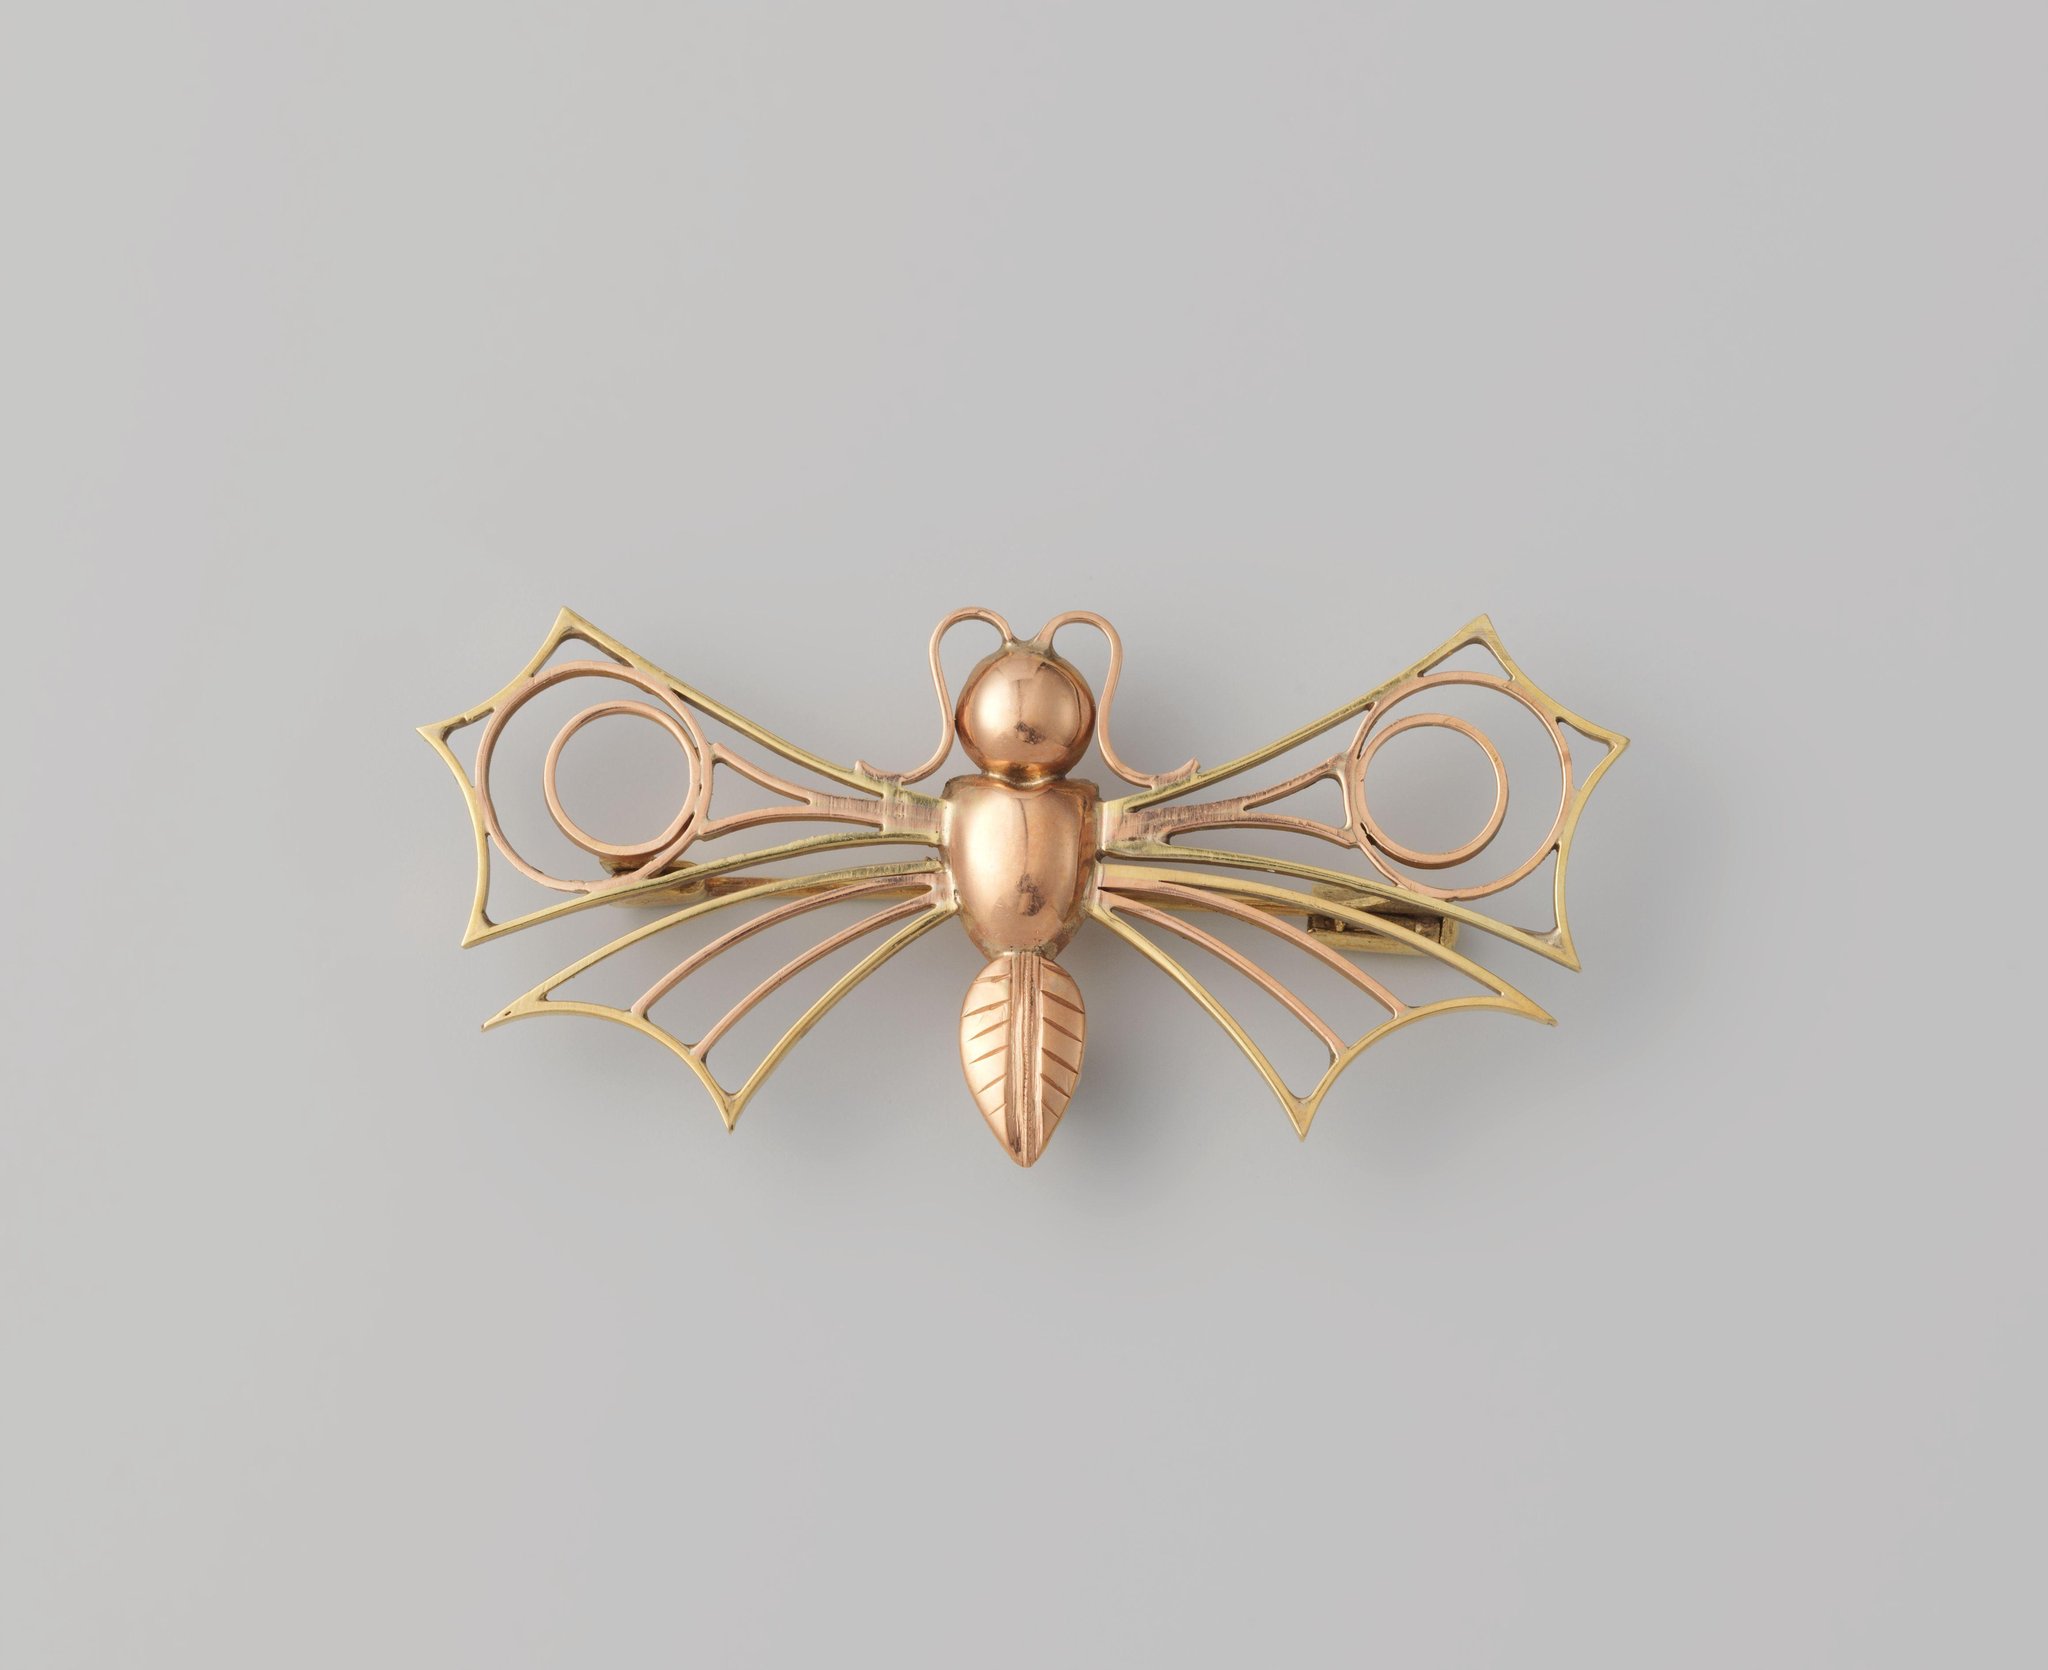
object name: lapel pin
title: Broche 'Bij'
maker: Anonymous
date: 1942-1953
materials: gold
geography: amsterdam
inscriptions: : ‘HH2’, alloy mark: ‘eikenblad’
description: Broche of reversspeld 'Bij', in twee kleuren goud. Samen met de pendant 'Bloem' staan de twee spelden symbool voor de geboortegolf na de Tweede Wereldoorlog. Het roodgouden hart van de bloem is hetzelfde als de kop van het insect. Het is echter onwaarschijnlijk dat de broches samen tegelijkertijd werden gedragen. De bij heeft een kanonsluiting.